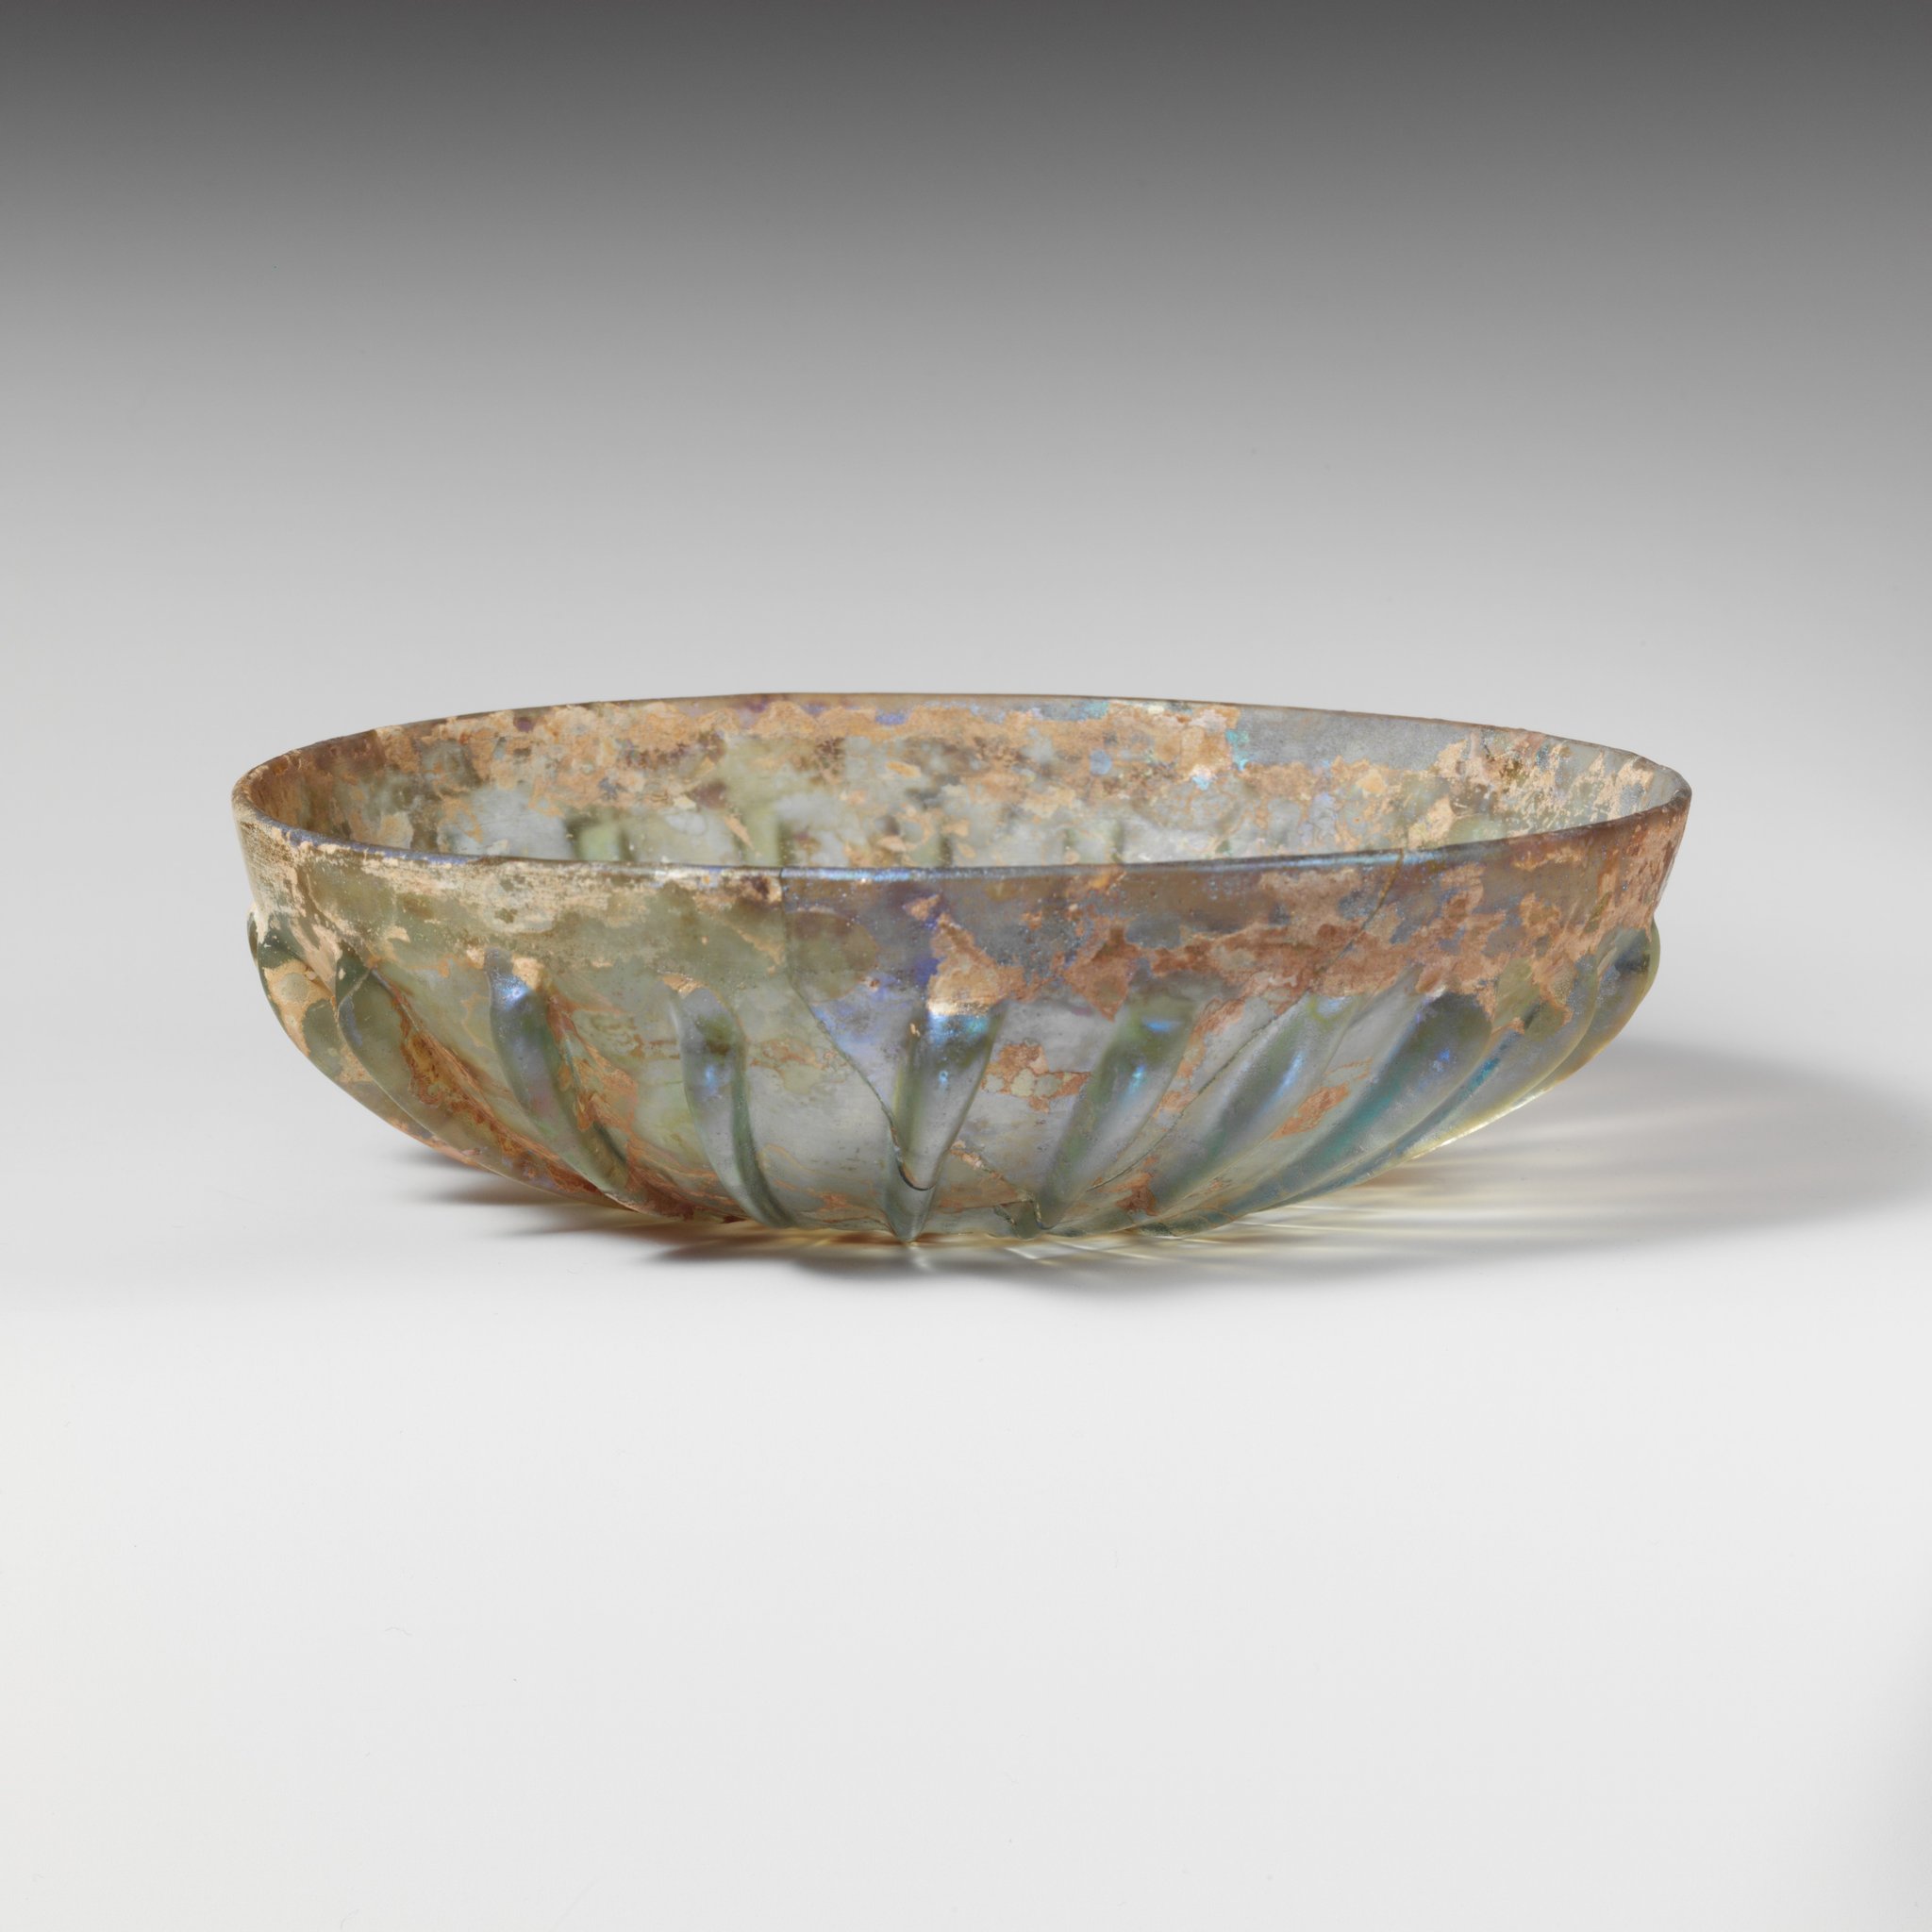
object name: bowl, ribbed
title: Glass ribbed bowl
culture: roman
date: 34 BCE-66 CE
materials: glass